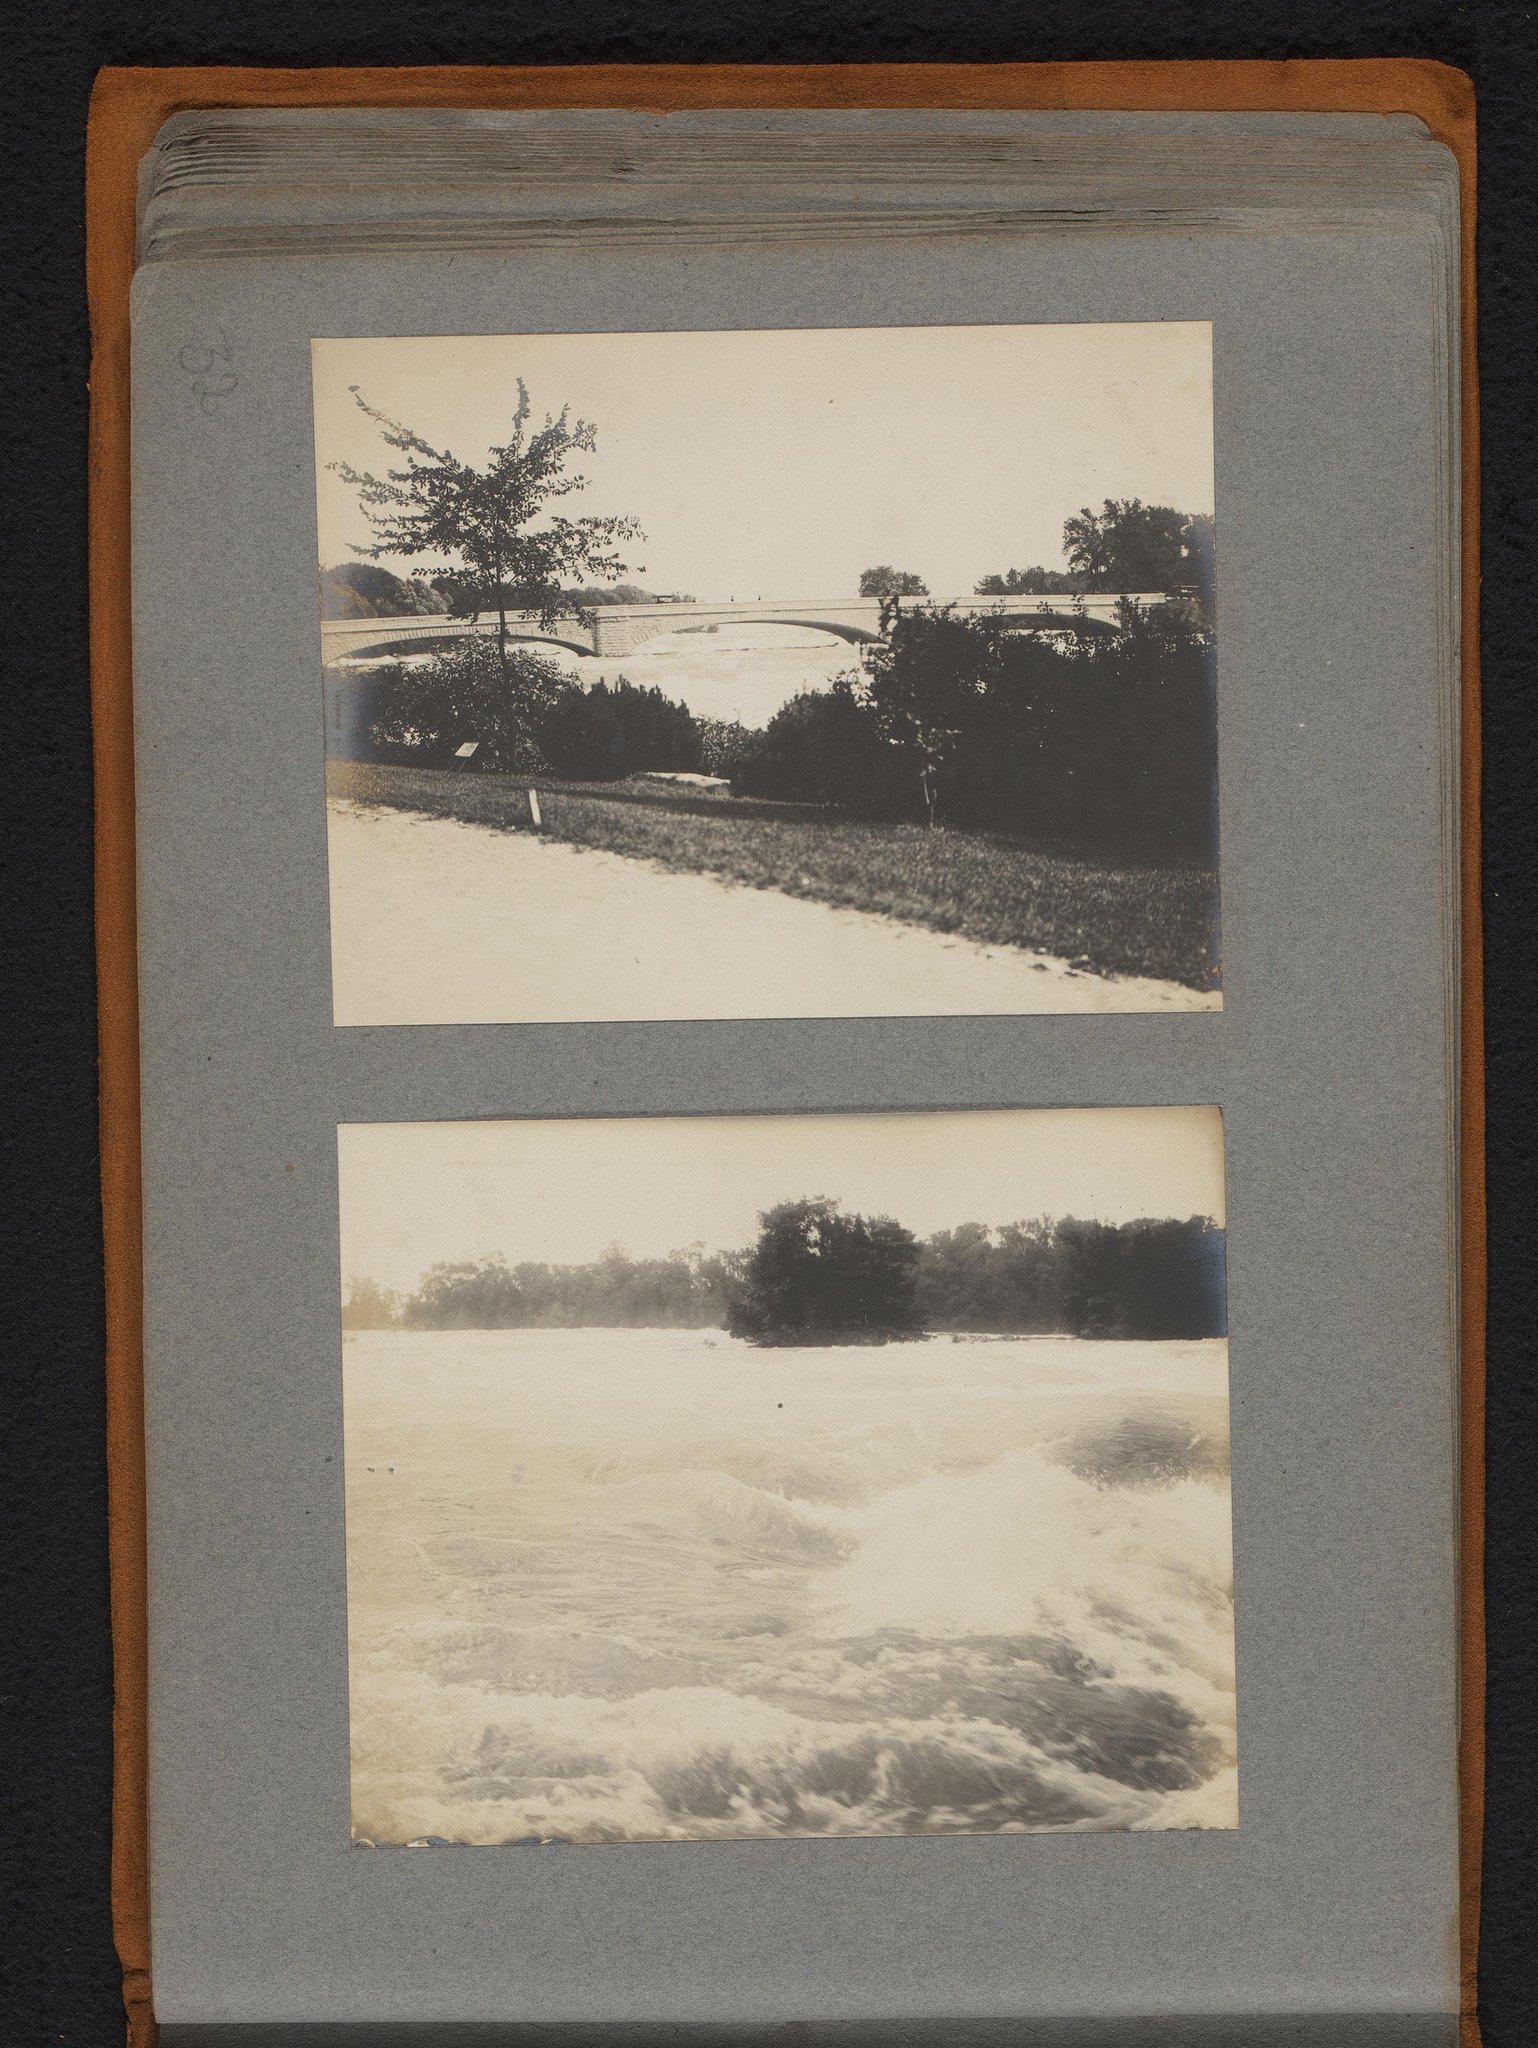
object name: photograph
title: Gezicht op de Goat Island brug en de Niagara rivier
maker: jan van der mey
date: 1902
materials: paper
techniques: gelatin silver print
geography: niagara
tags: rapids, river, landscape with bridge, viaduct or aqueduct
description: Deze foto's maken deel uit van een album.